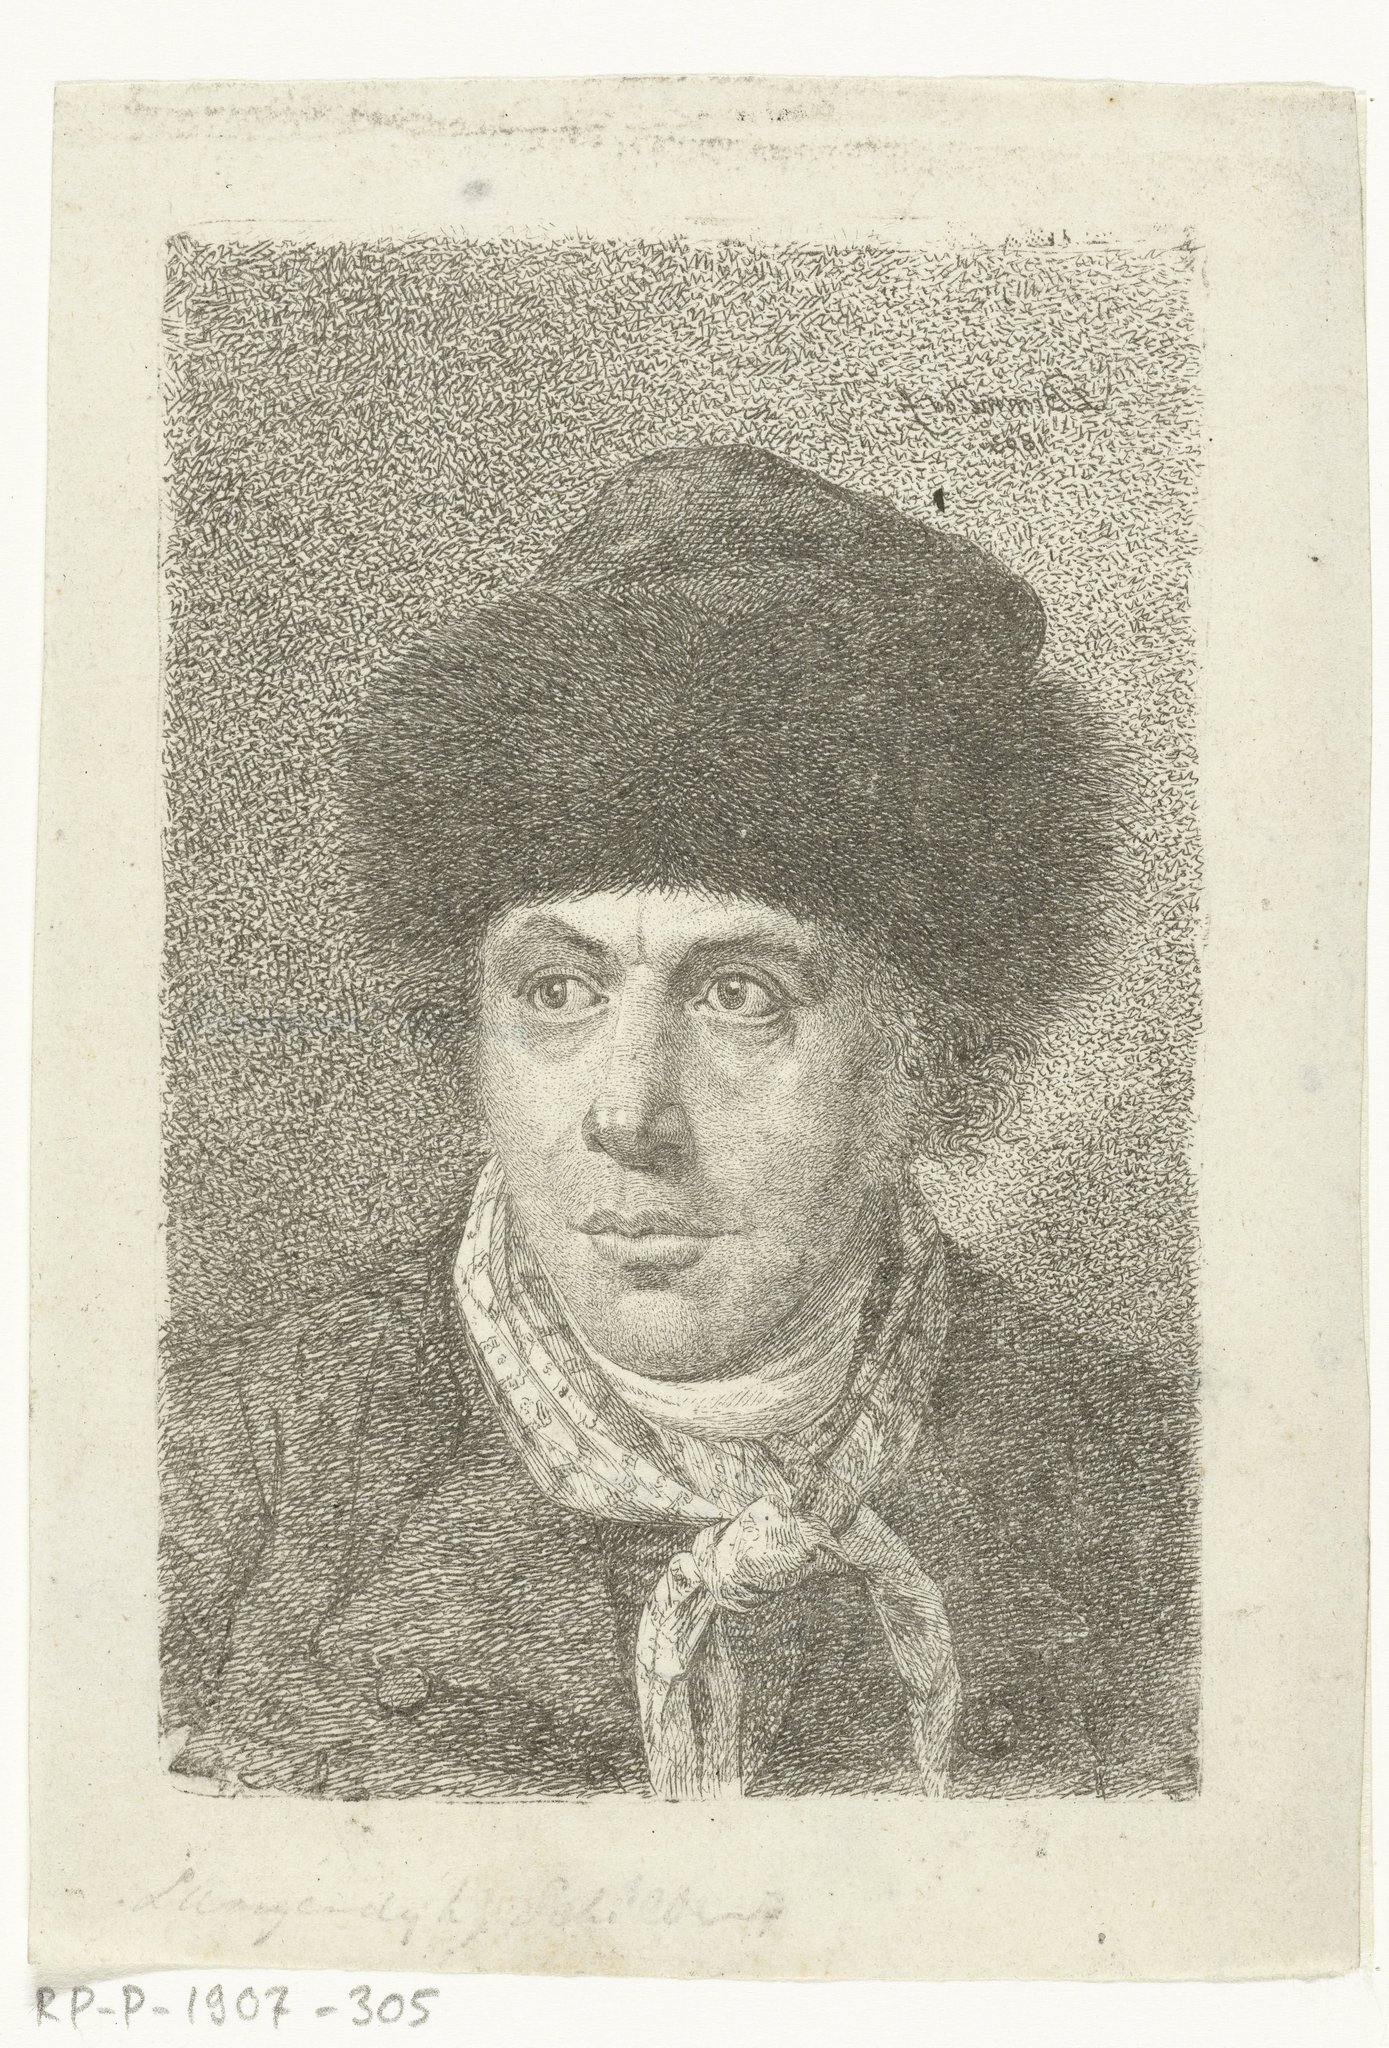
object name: print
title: Portret van Dirk Langendijk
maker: joannes bemme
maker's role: print maker, printer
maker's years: 1775-1841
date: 1805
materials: paper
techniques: etching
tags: painter, print maker, draughtsman, dirk langendijk, art (+ portrait, self-portrait of artist)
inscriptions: collector's mark: Lugt 2228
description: Portret van de kunstenaar Dirk Langendijk met bontmuts.